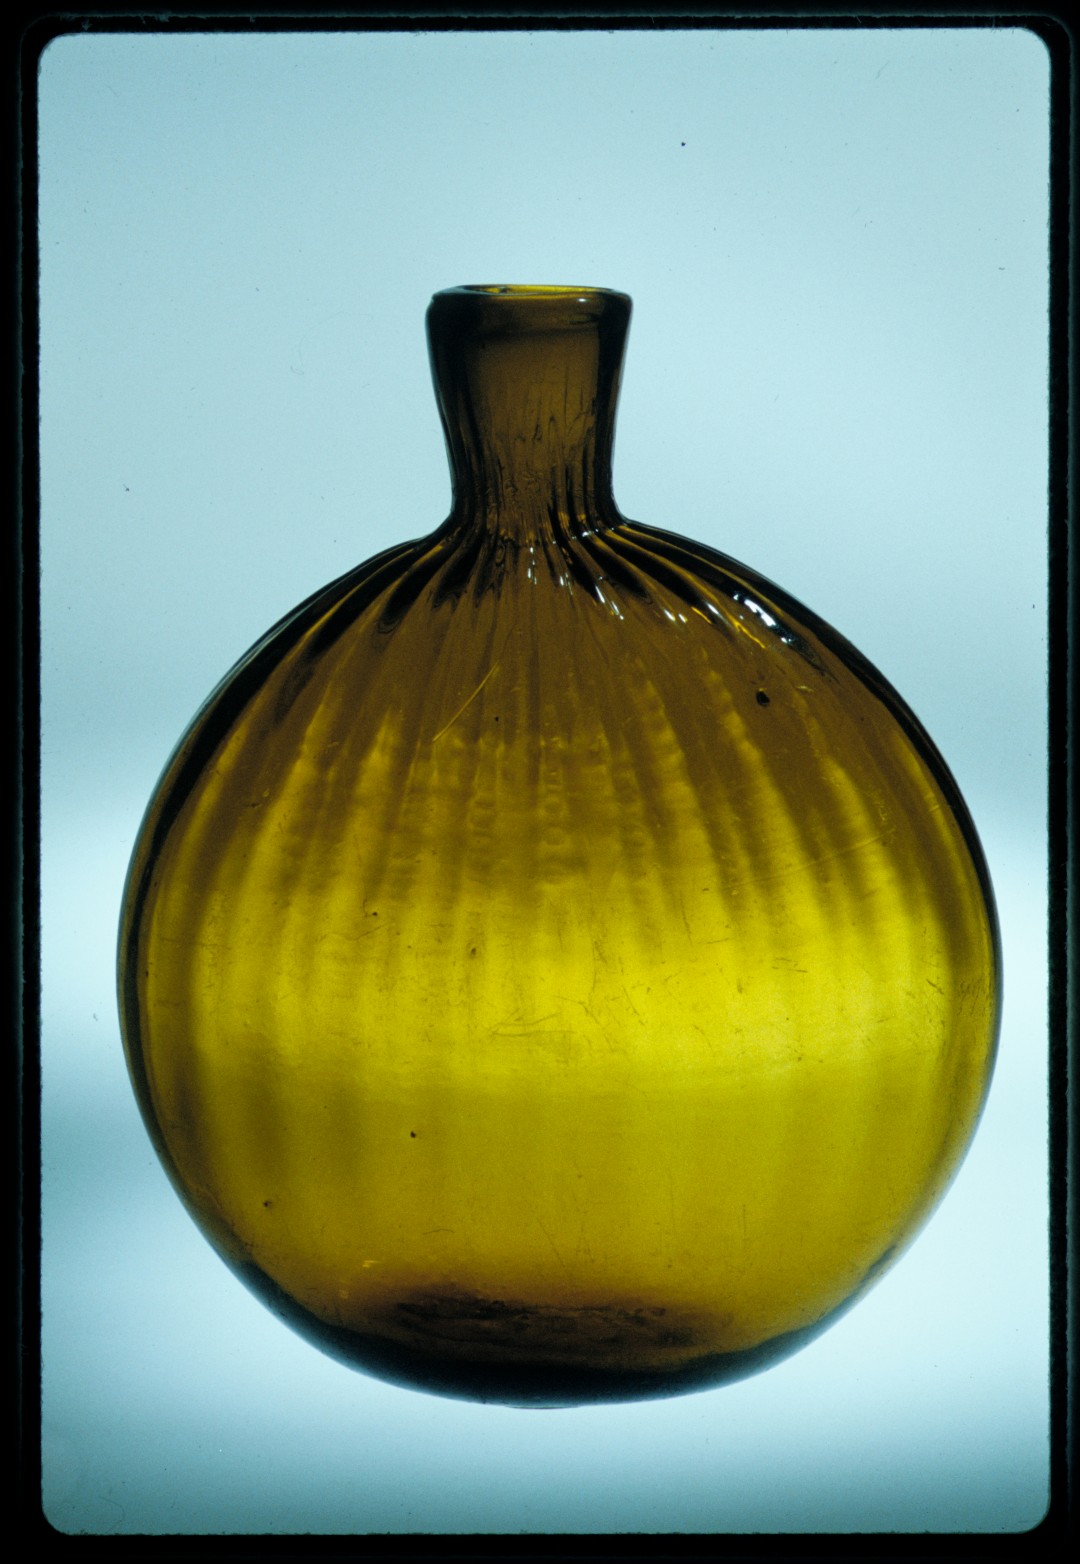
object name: bottle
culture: american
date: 1820-1840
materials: glass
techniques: glassblowing, molding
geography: united states